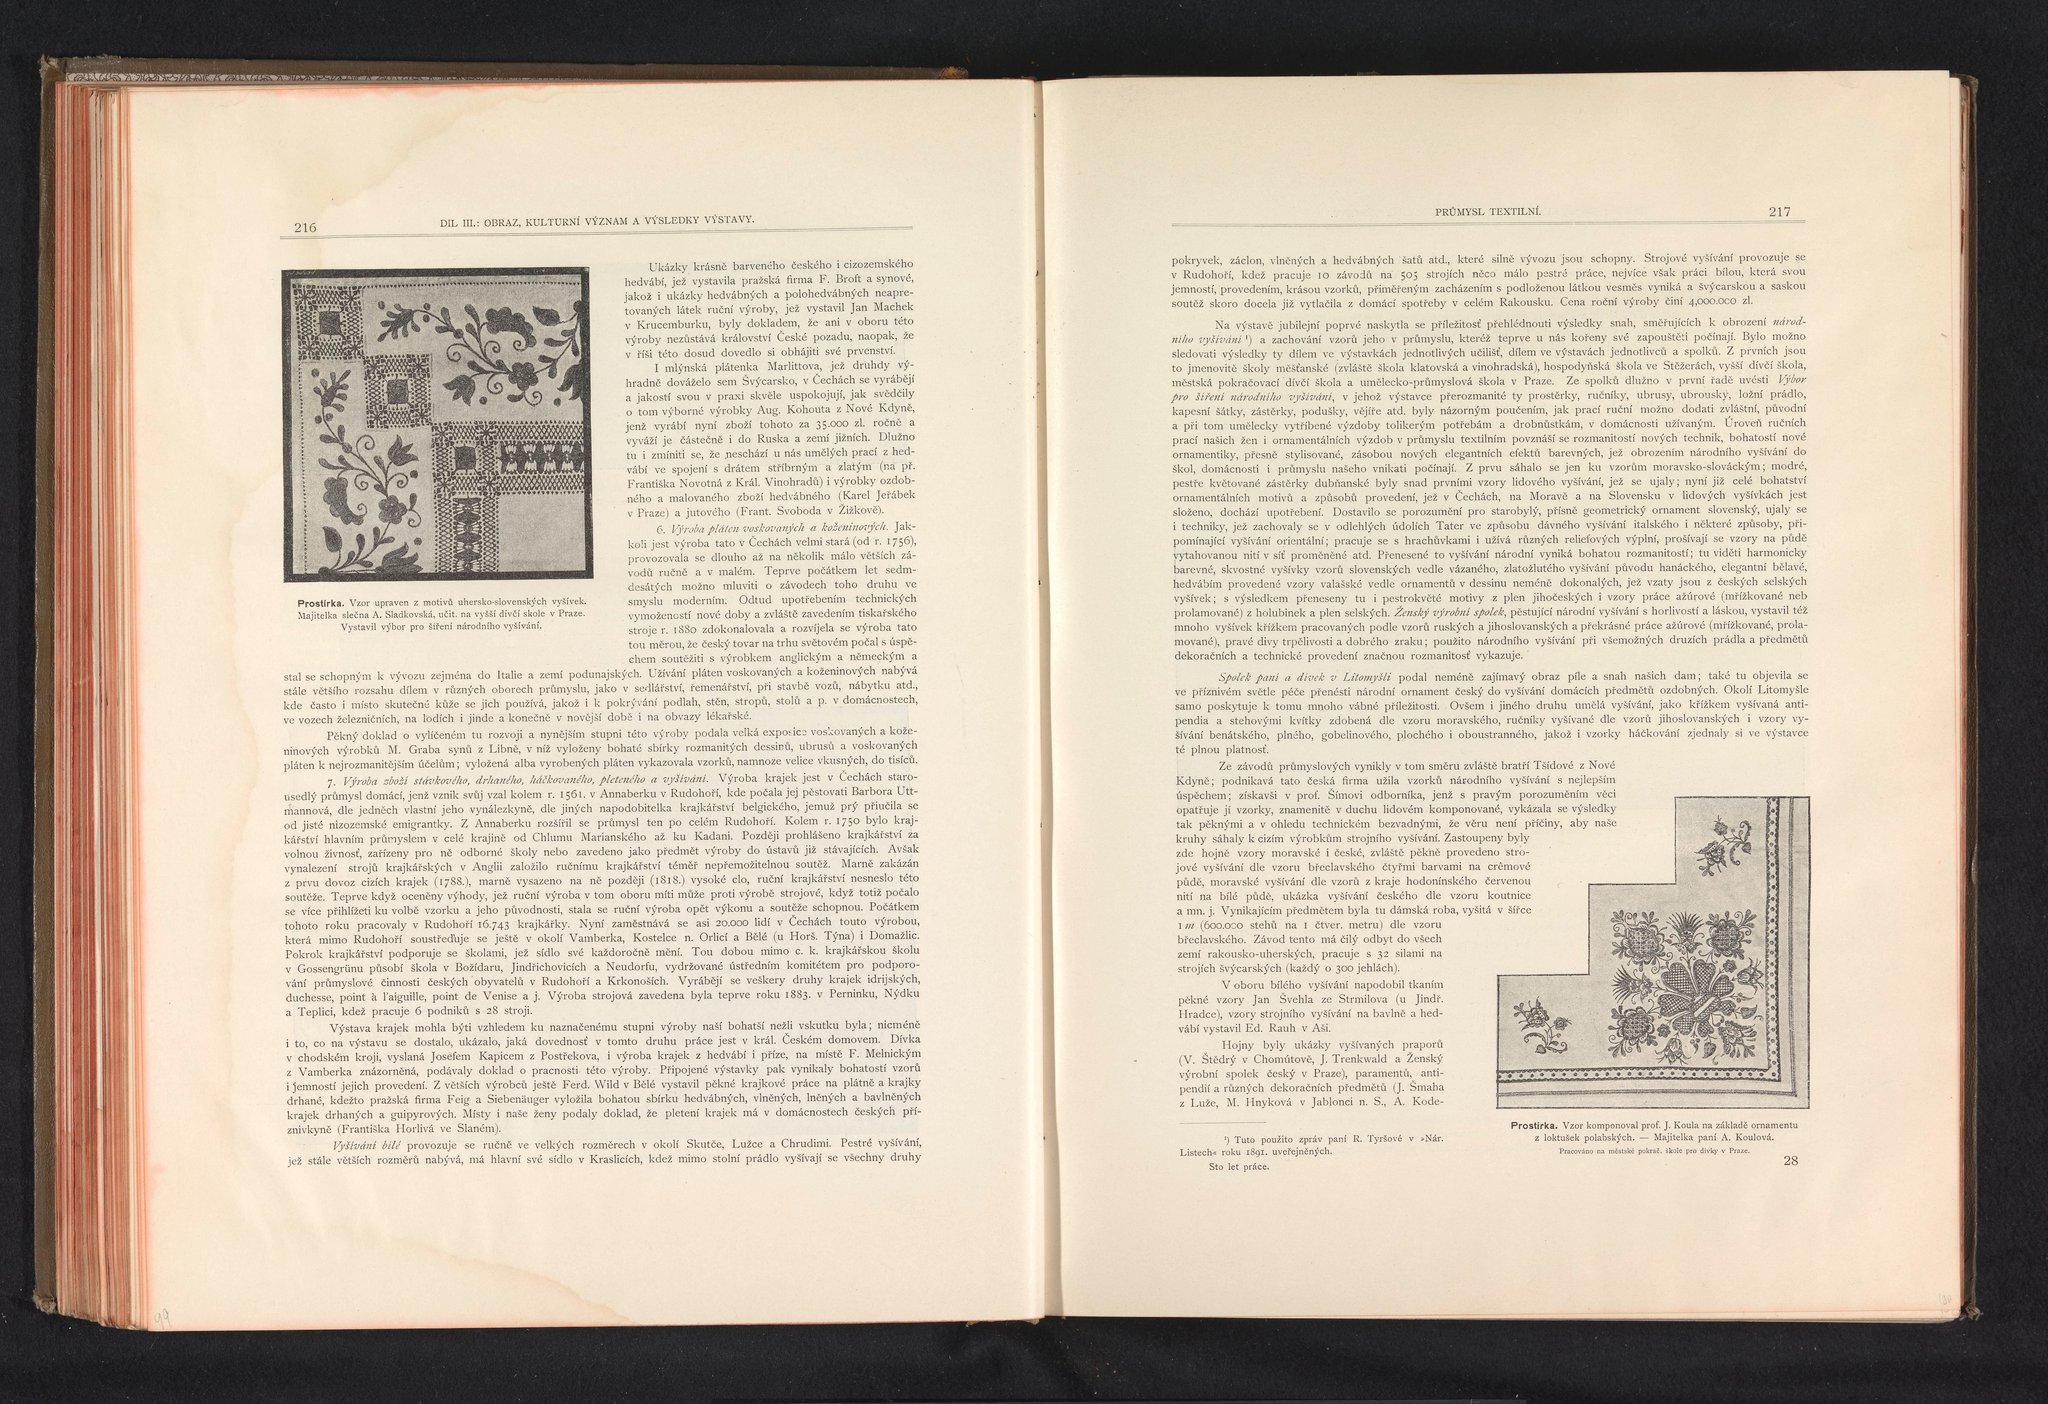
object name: page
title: Prostirka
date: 1890-1895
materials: paper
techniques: autotype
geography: prague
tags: embroidering ~ textile industry, table-ware